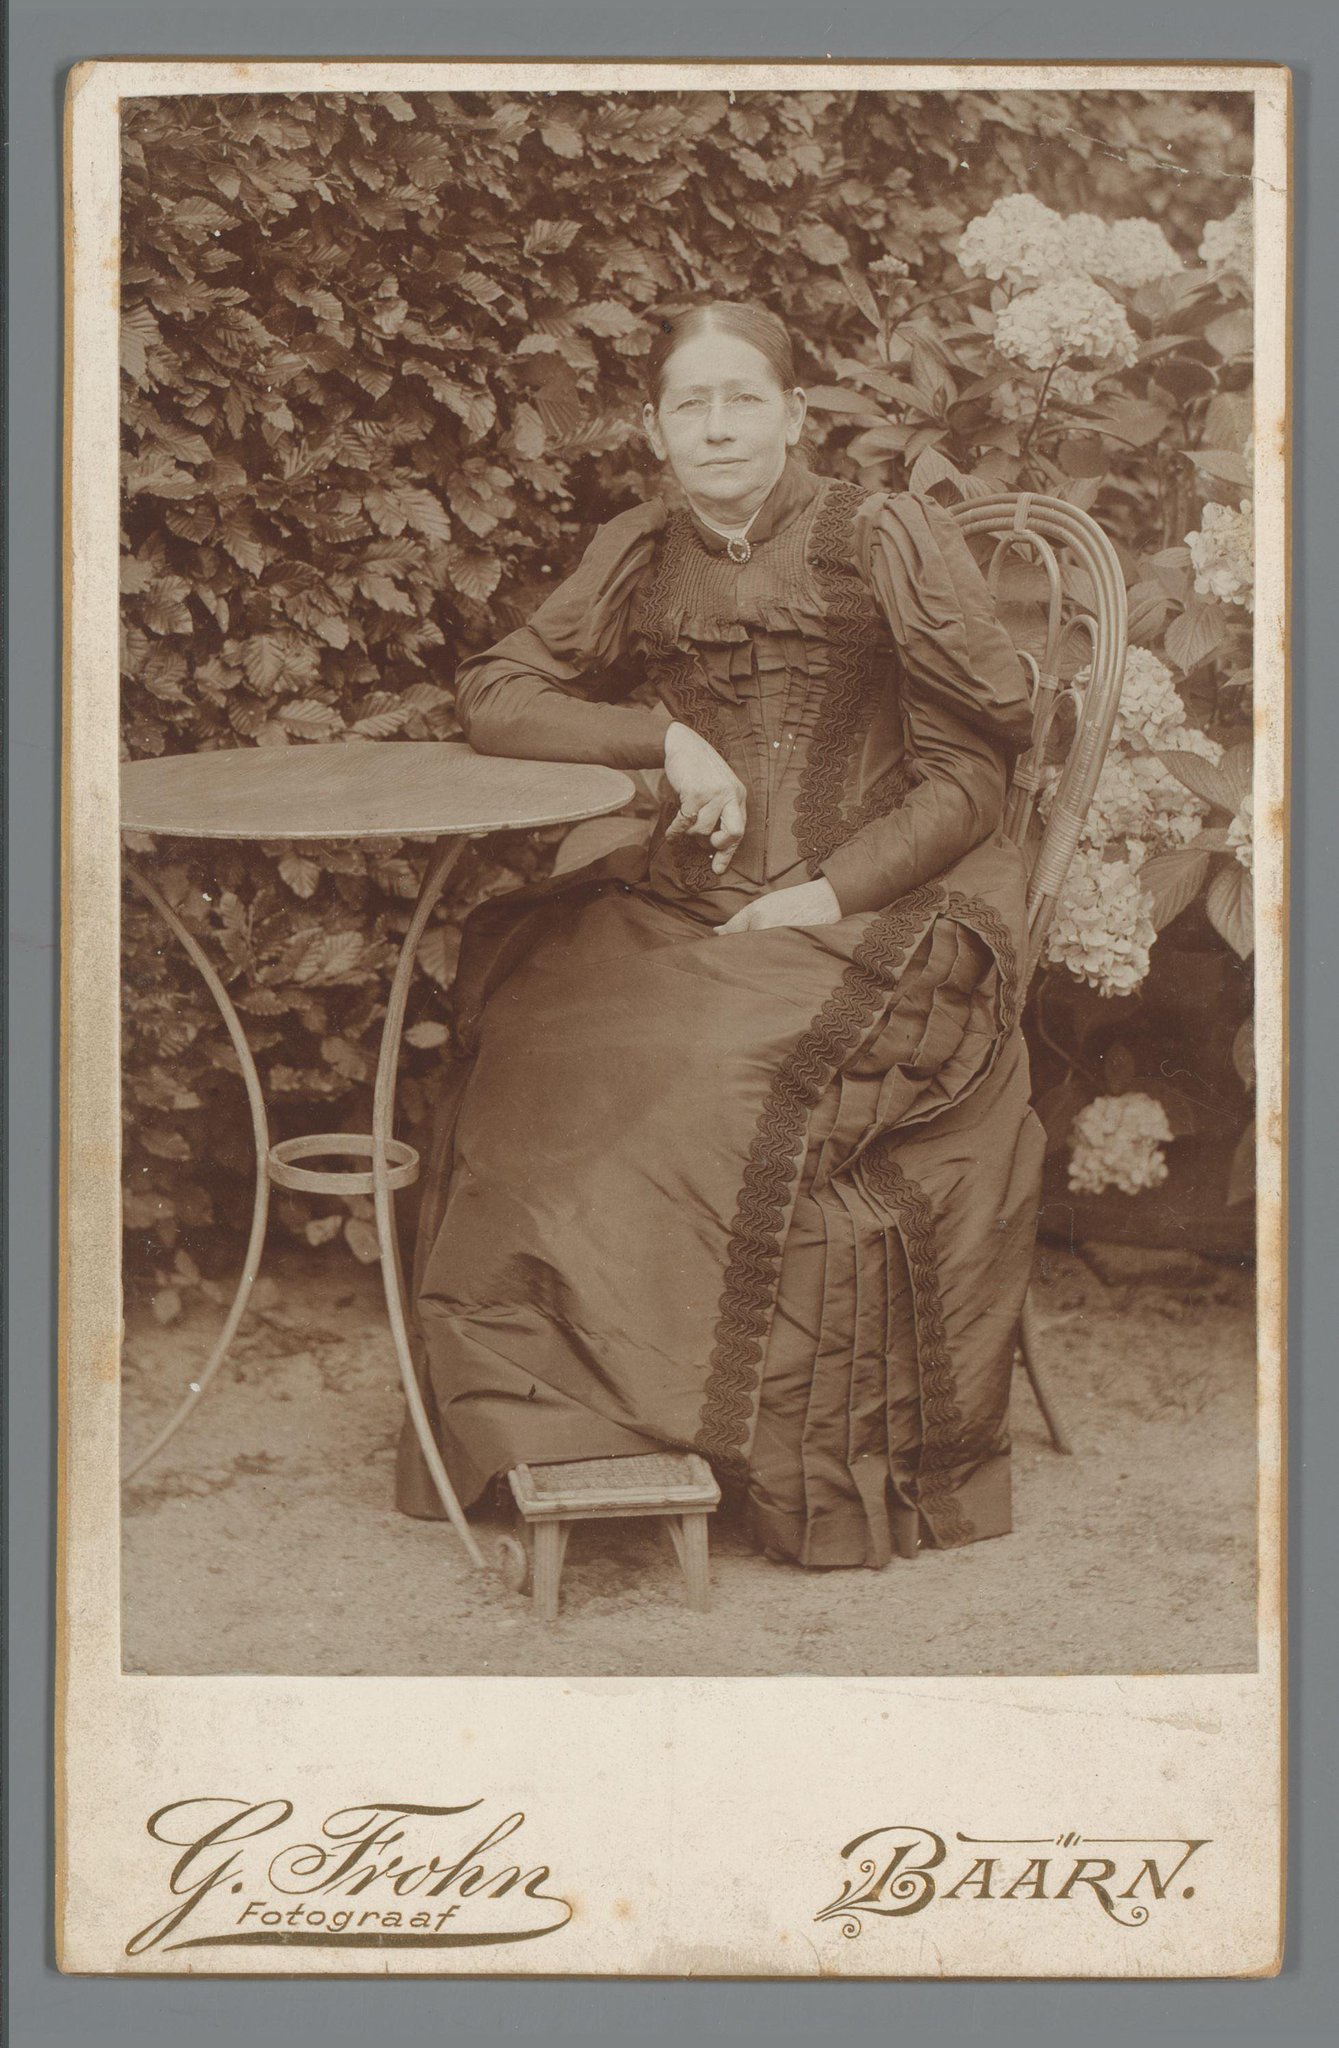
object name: cabinet photograph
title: Portret van Cornelia Hendrika Nije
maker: gerardus george johannes mathijs frohn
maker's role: fotograaf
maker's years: 1871-1910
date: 1890-1910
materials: cardboard, photographic support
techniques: collodion silver print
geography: baarn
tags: historical persons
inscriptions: annotation: ‘C.H. Nije/ Zuster van J.G. Jonker-Nije’